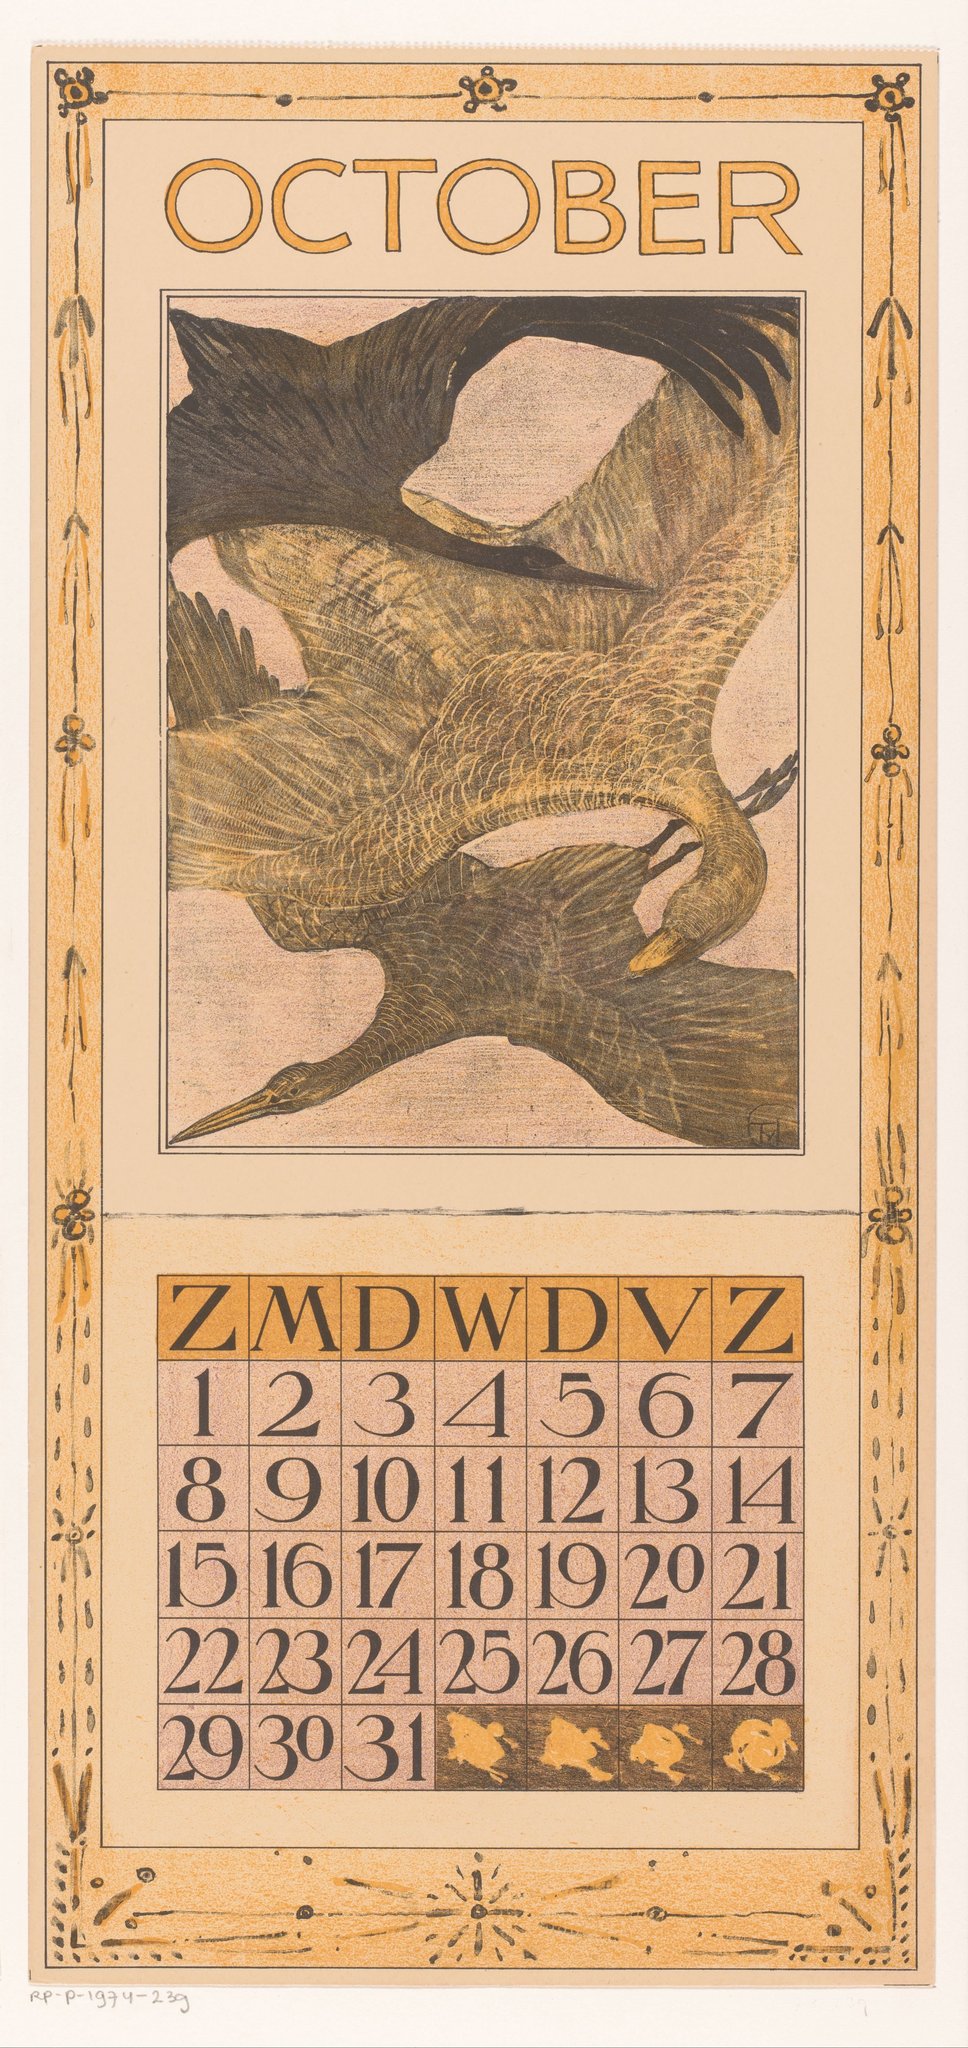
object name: calendar leaf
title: Kalender 1905 12 lithografien door Th. v. Hoytema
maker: theo van hoytema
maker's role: draughtsman, painter, print maker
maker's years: 1863-1917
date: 1904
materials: paper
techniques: lithograph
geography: amsterdam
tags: birds, october ~ other concepts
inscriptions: collector's mark: Lugt 2228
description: De vogels vliegen door elkaar heen. Bovenaan het blad een scheurlijn.